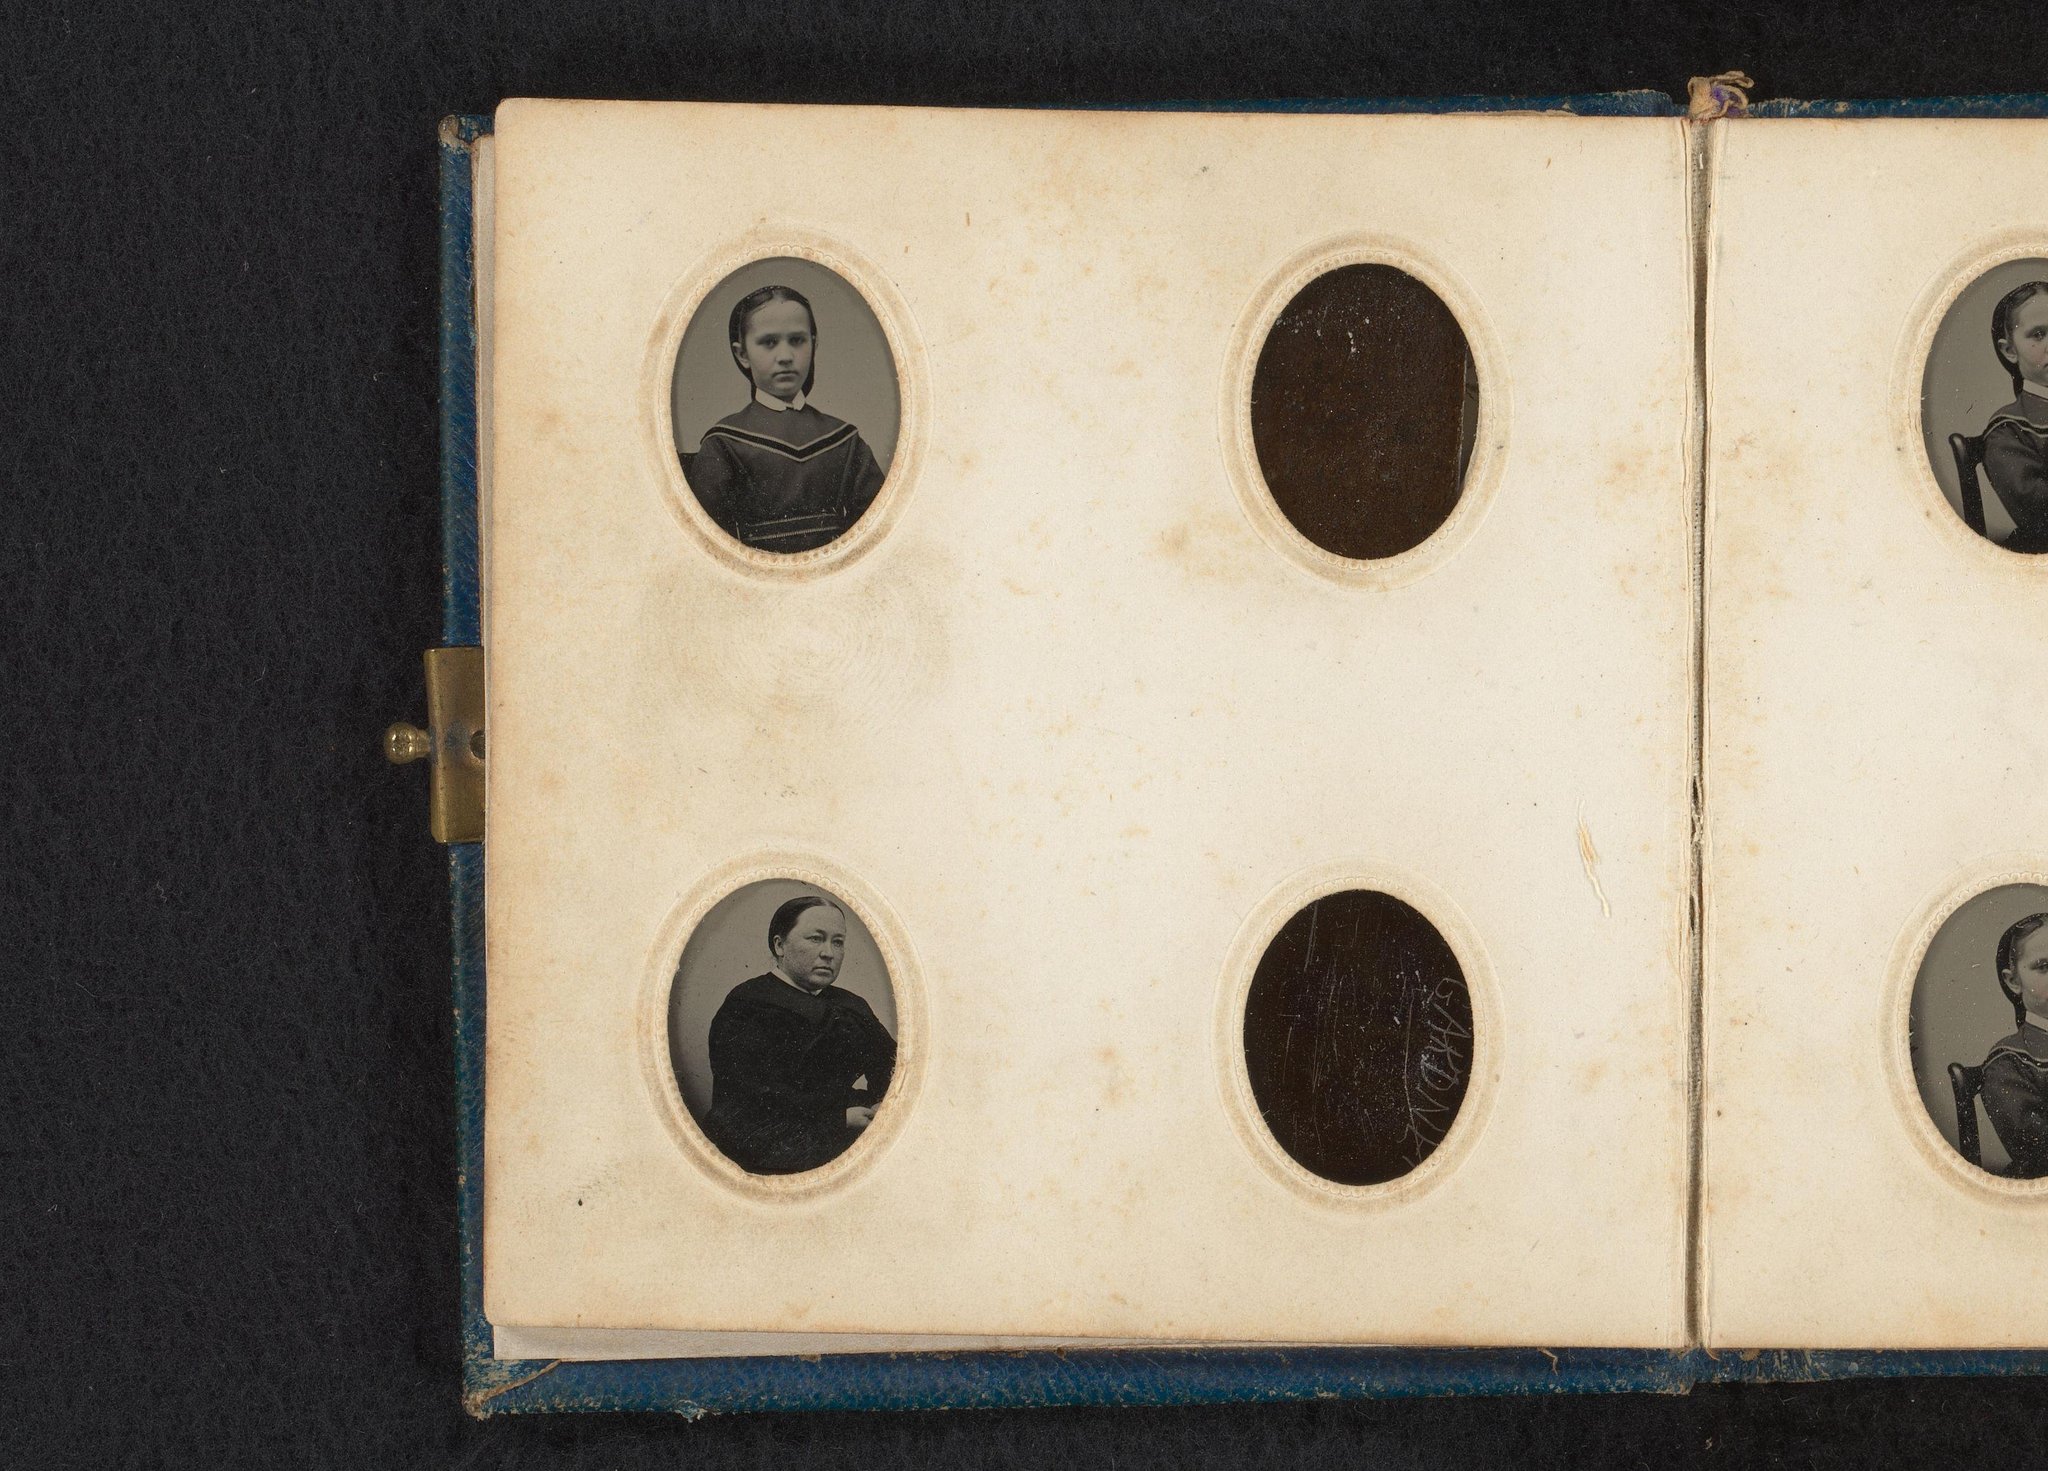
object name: album leaf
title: Twee portretten van een meisje en een vrouw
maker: Anonymous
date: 1855-1900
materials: cardboard, iron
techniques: ferrotyping, hand coloring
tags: historical persons not known by name - bb - woman, girl (child between toddler and youth)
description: Deze foto's maken deel uit van een album.